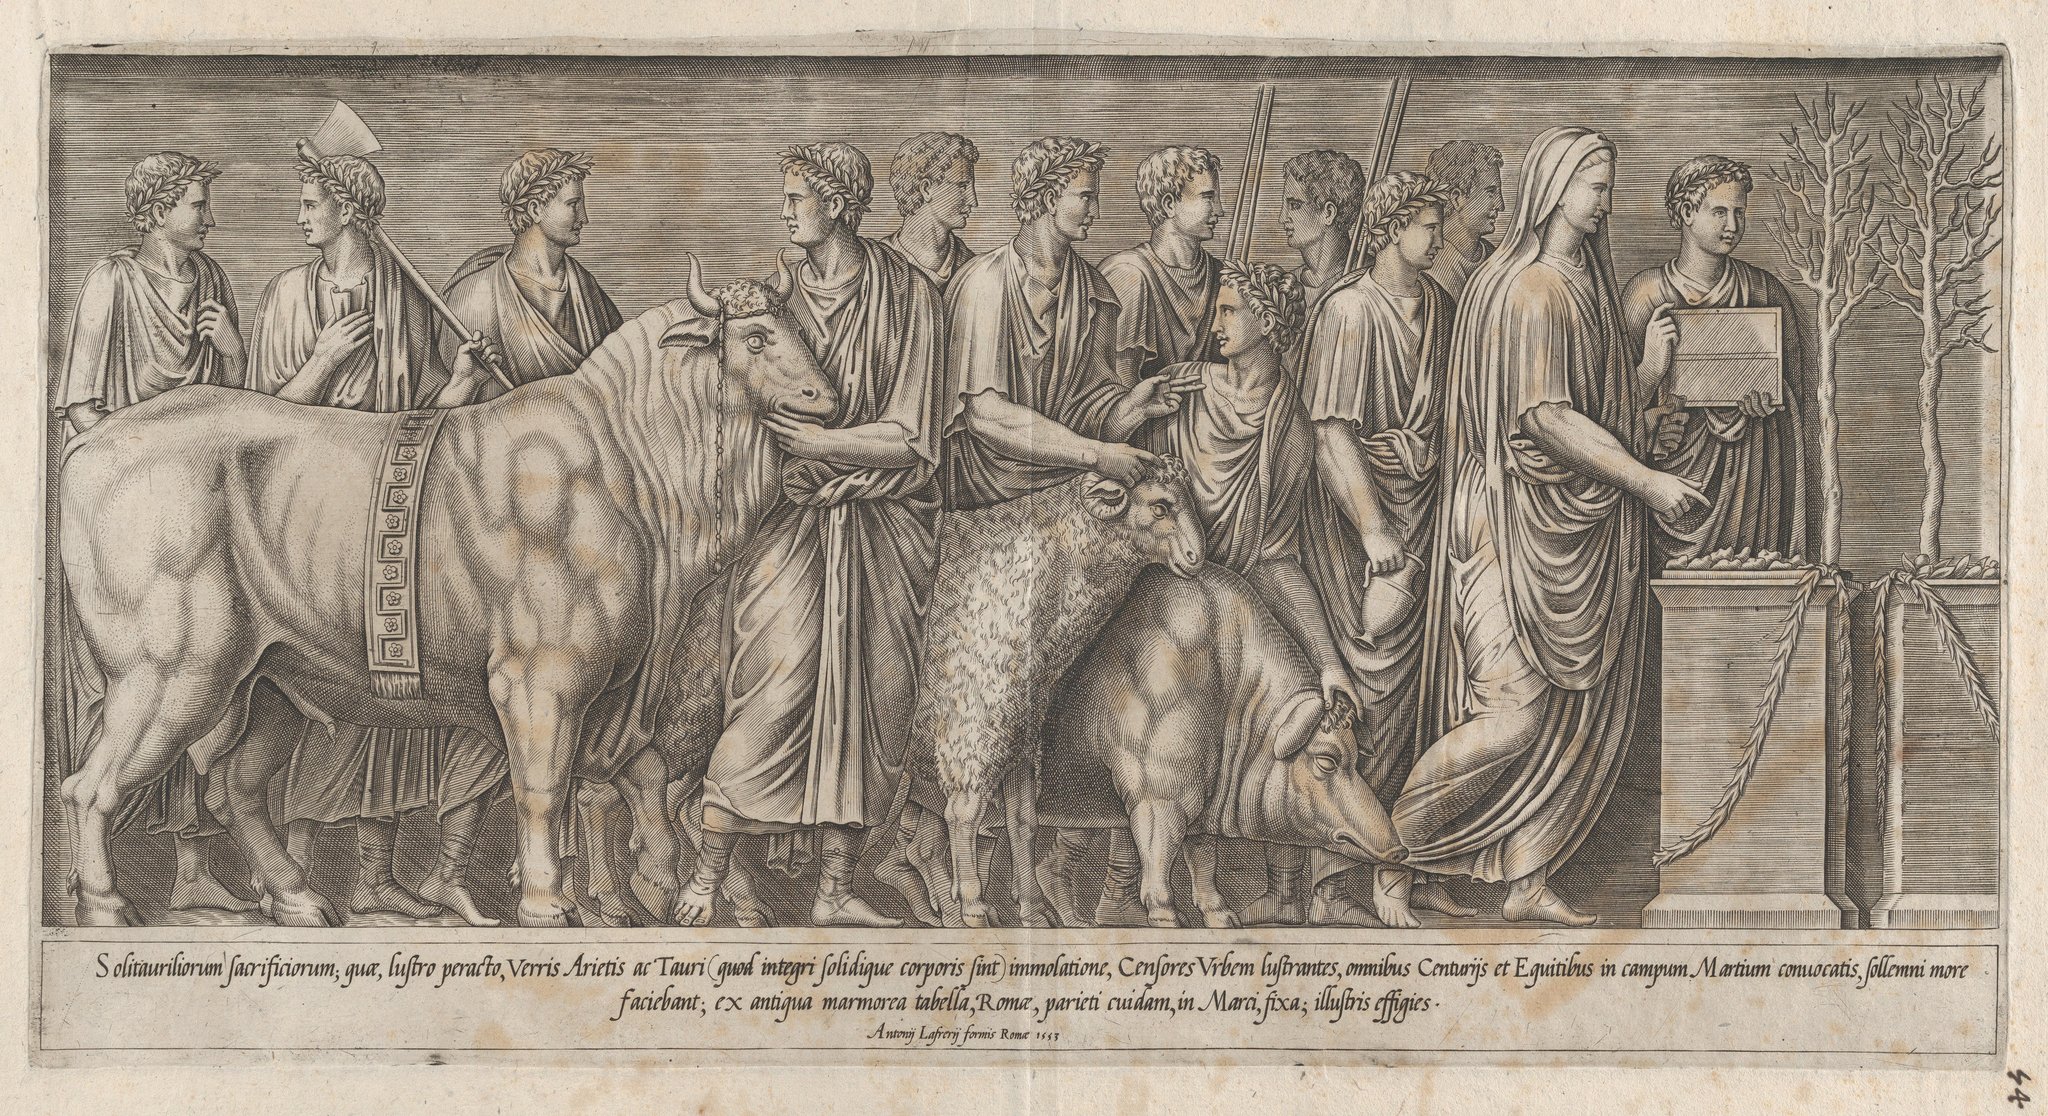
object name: print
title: Sacrifice on the Campus Martius, from "Speculum Romanae Magnificentiae"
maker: Anonymous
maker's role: artist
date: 1553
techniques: engraving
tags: animals,weapons,men,women